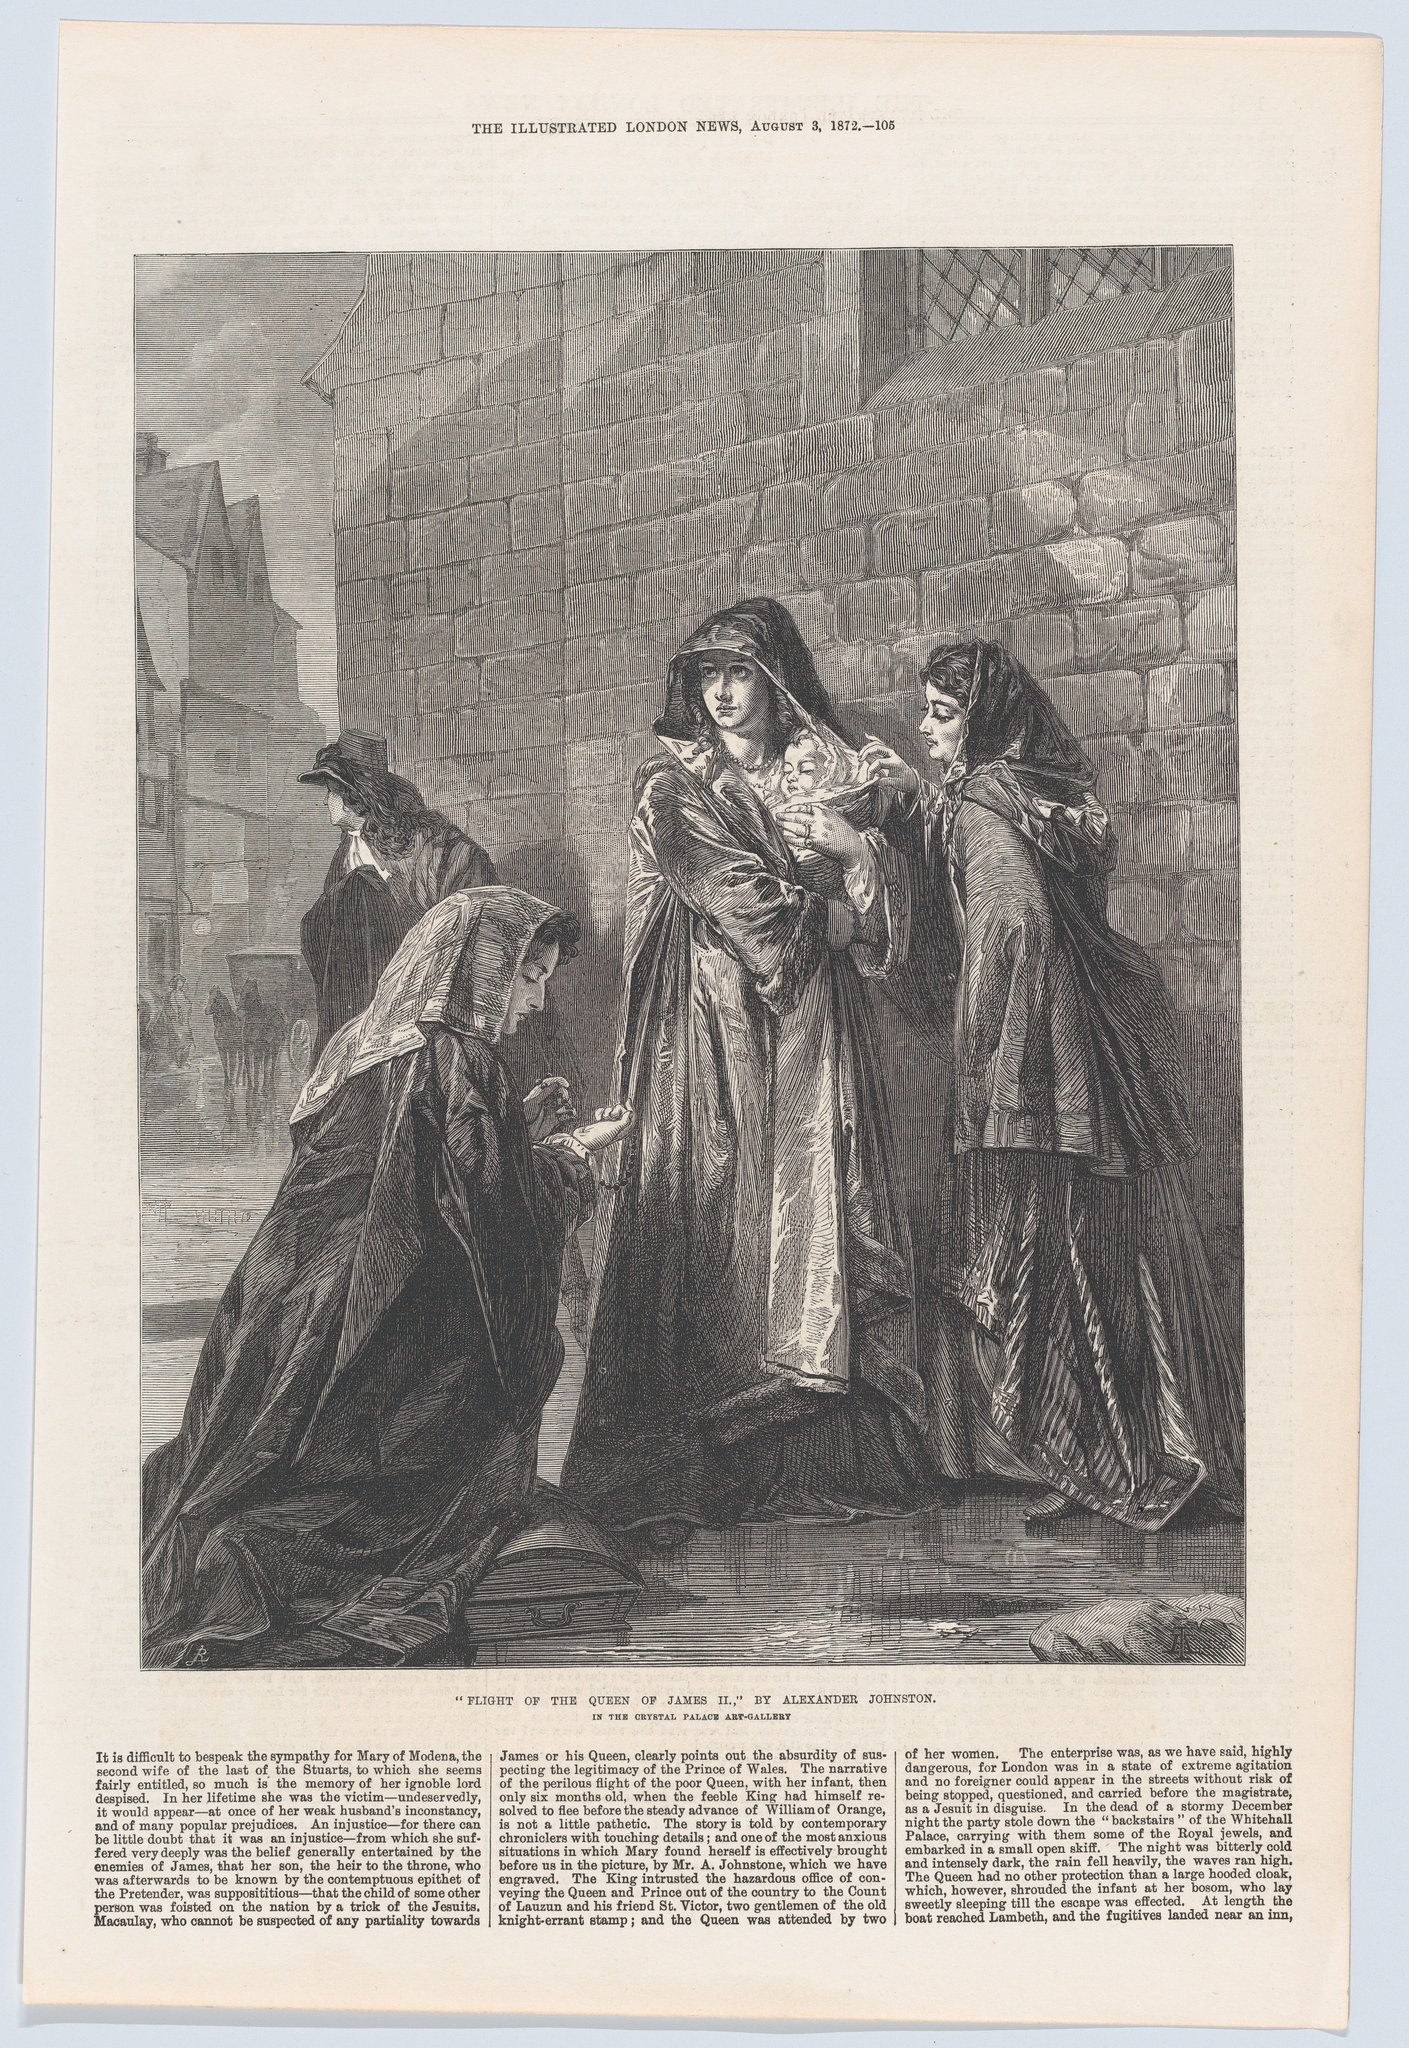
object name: print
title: Flight of the Queen of James II, from "Illustrated London News"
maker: richard principal leitch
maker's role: engraver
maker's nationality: british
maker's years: 1826-1882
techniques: engraving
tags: queens,infants,women